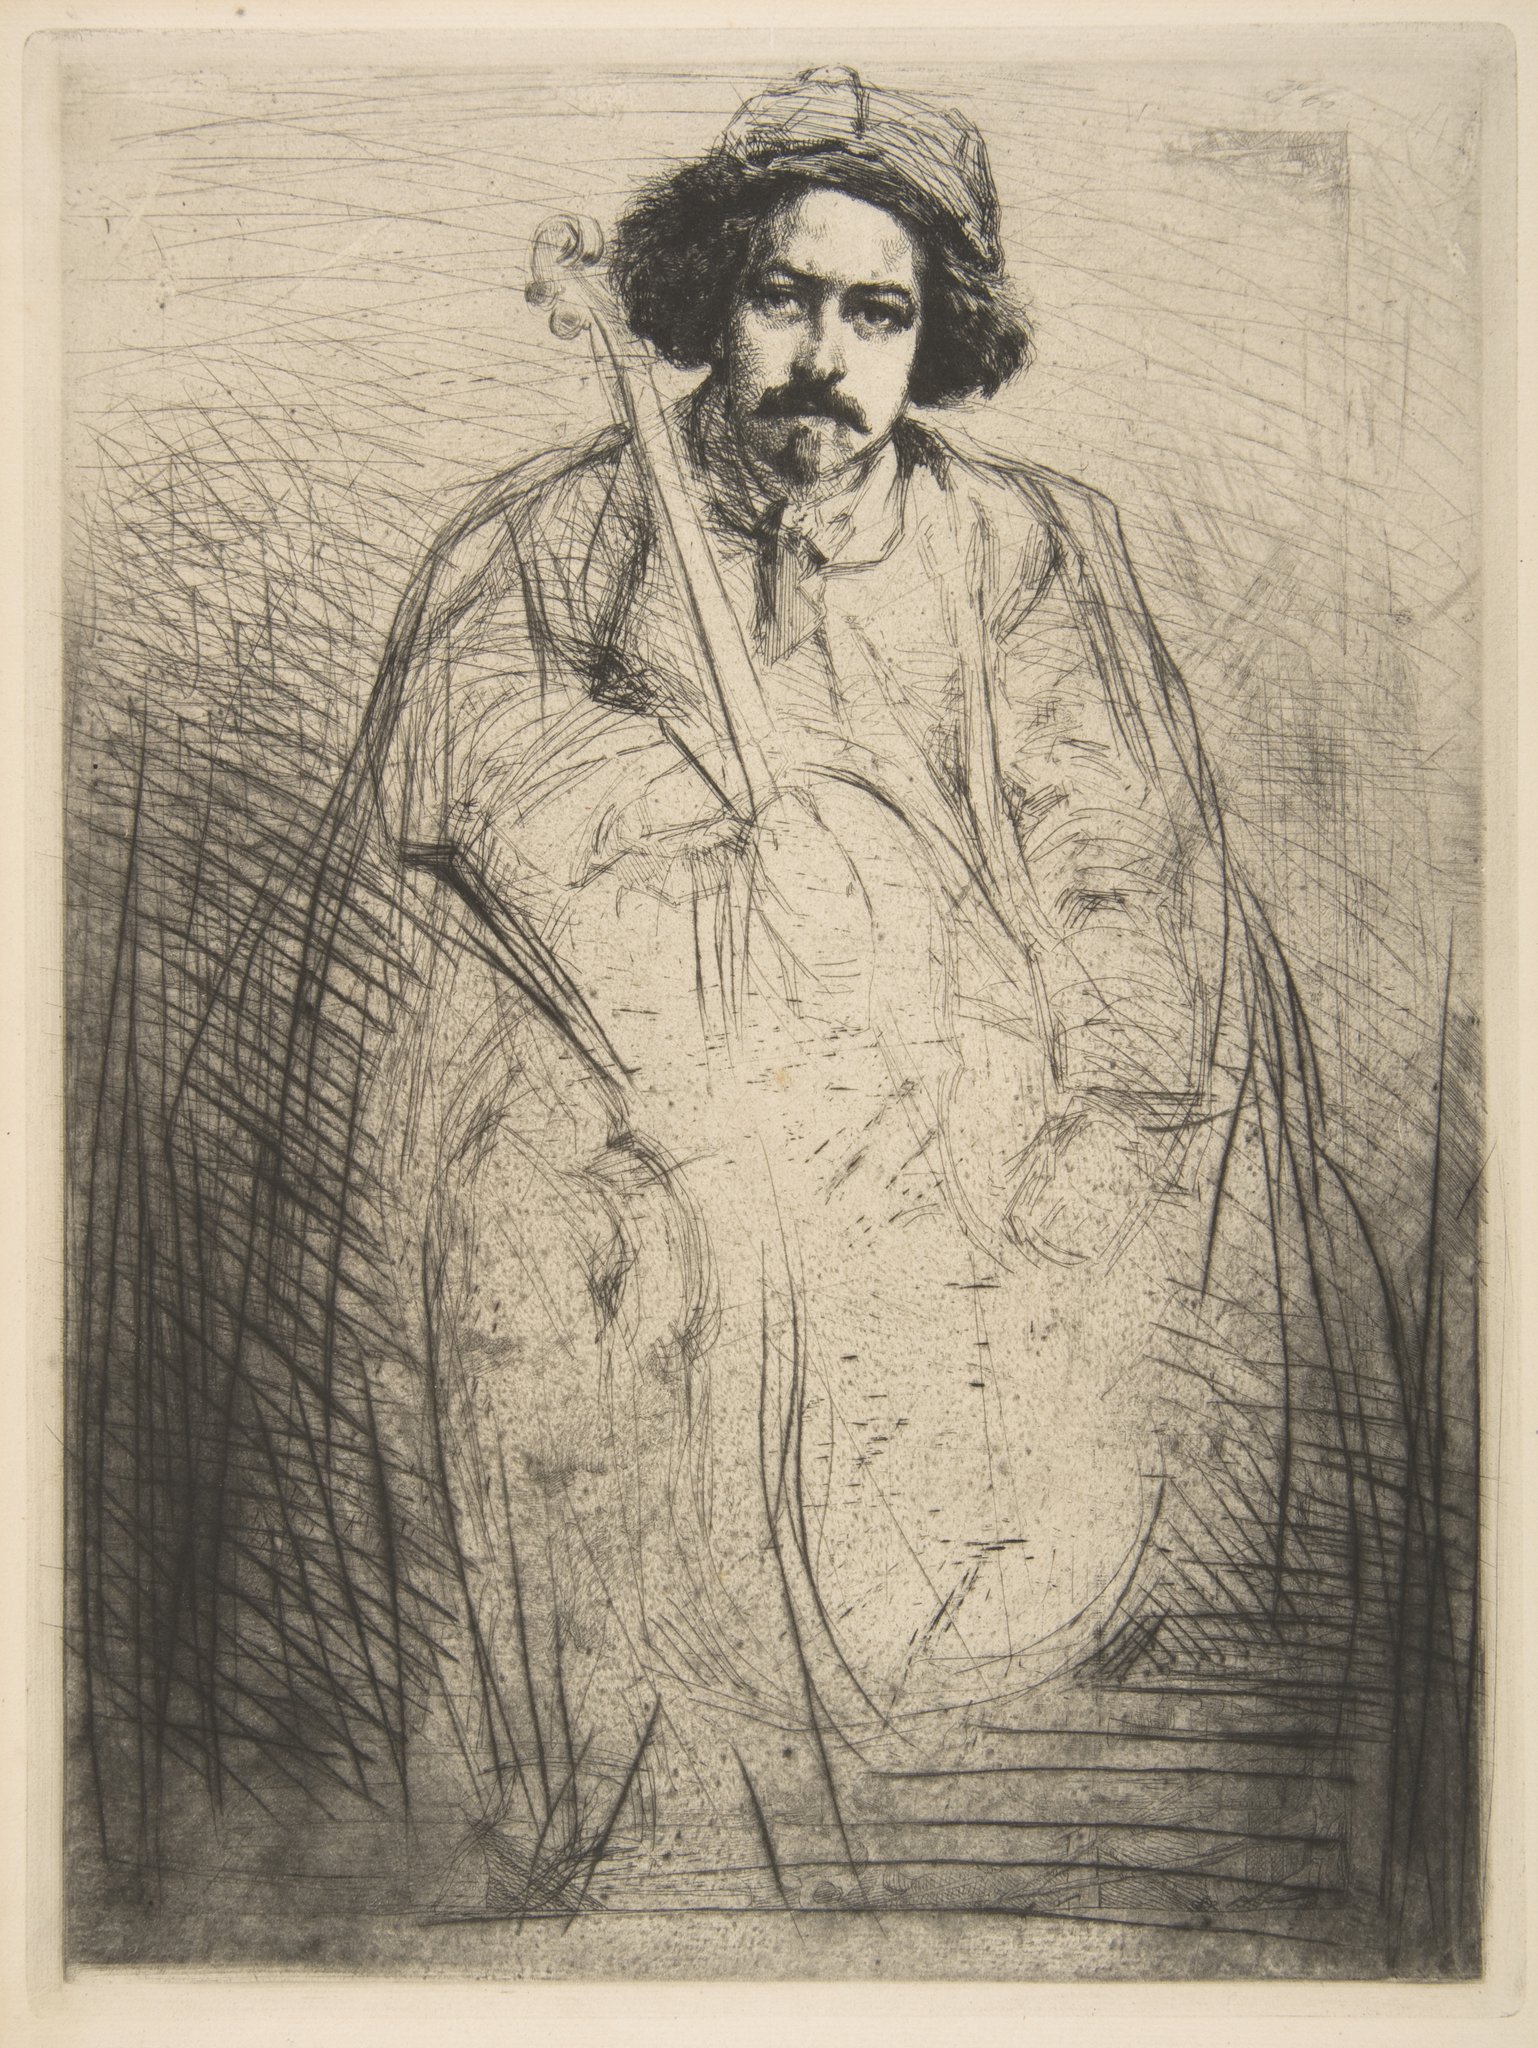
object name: print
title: Becquet (J. Becquet, Sculptor)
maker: james mcneill whistler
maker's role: artist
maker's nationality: american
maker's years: 1834-1903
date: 1859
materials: ink, paper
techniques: drypoint, etching, printing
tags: musical instruments,men